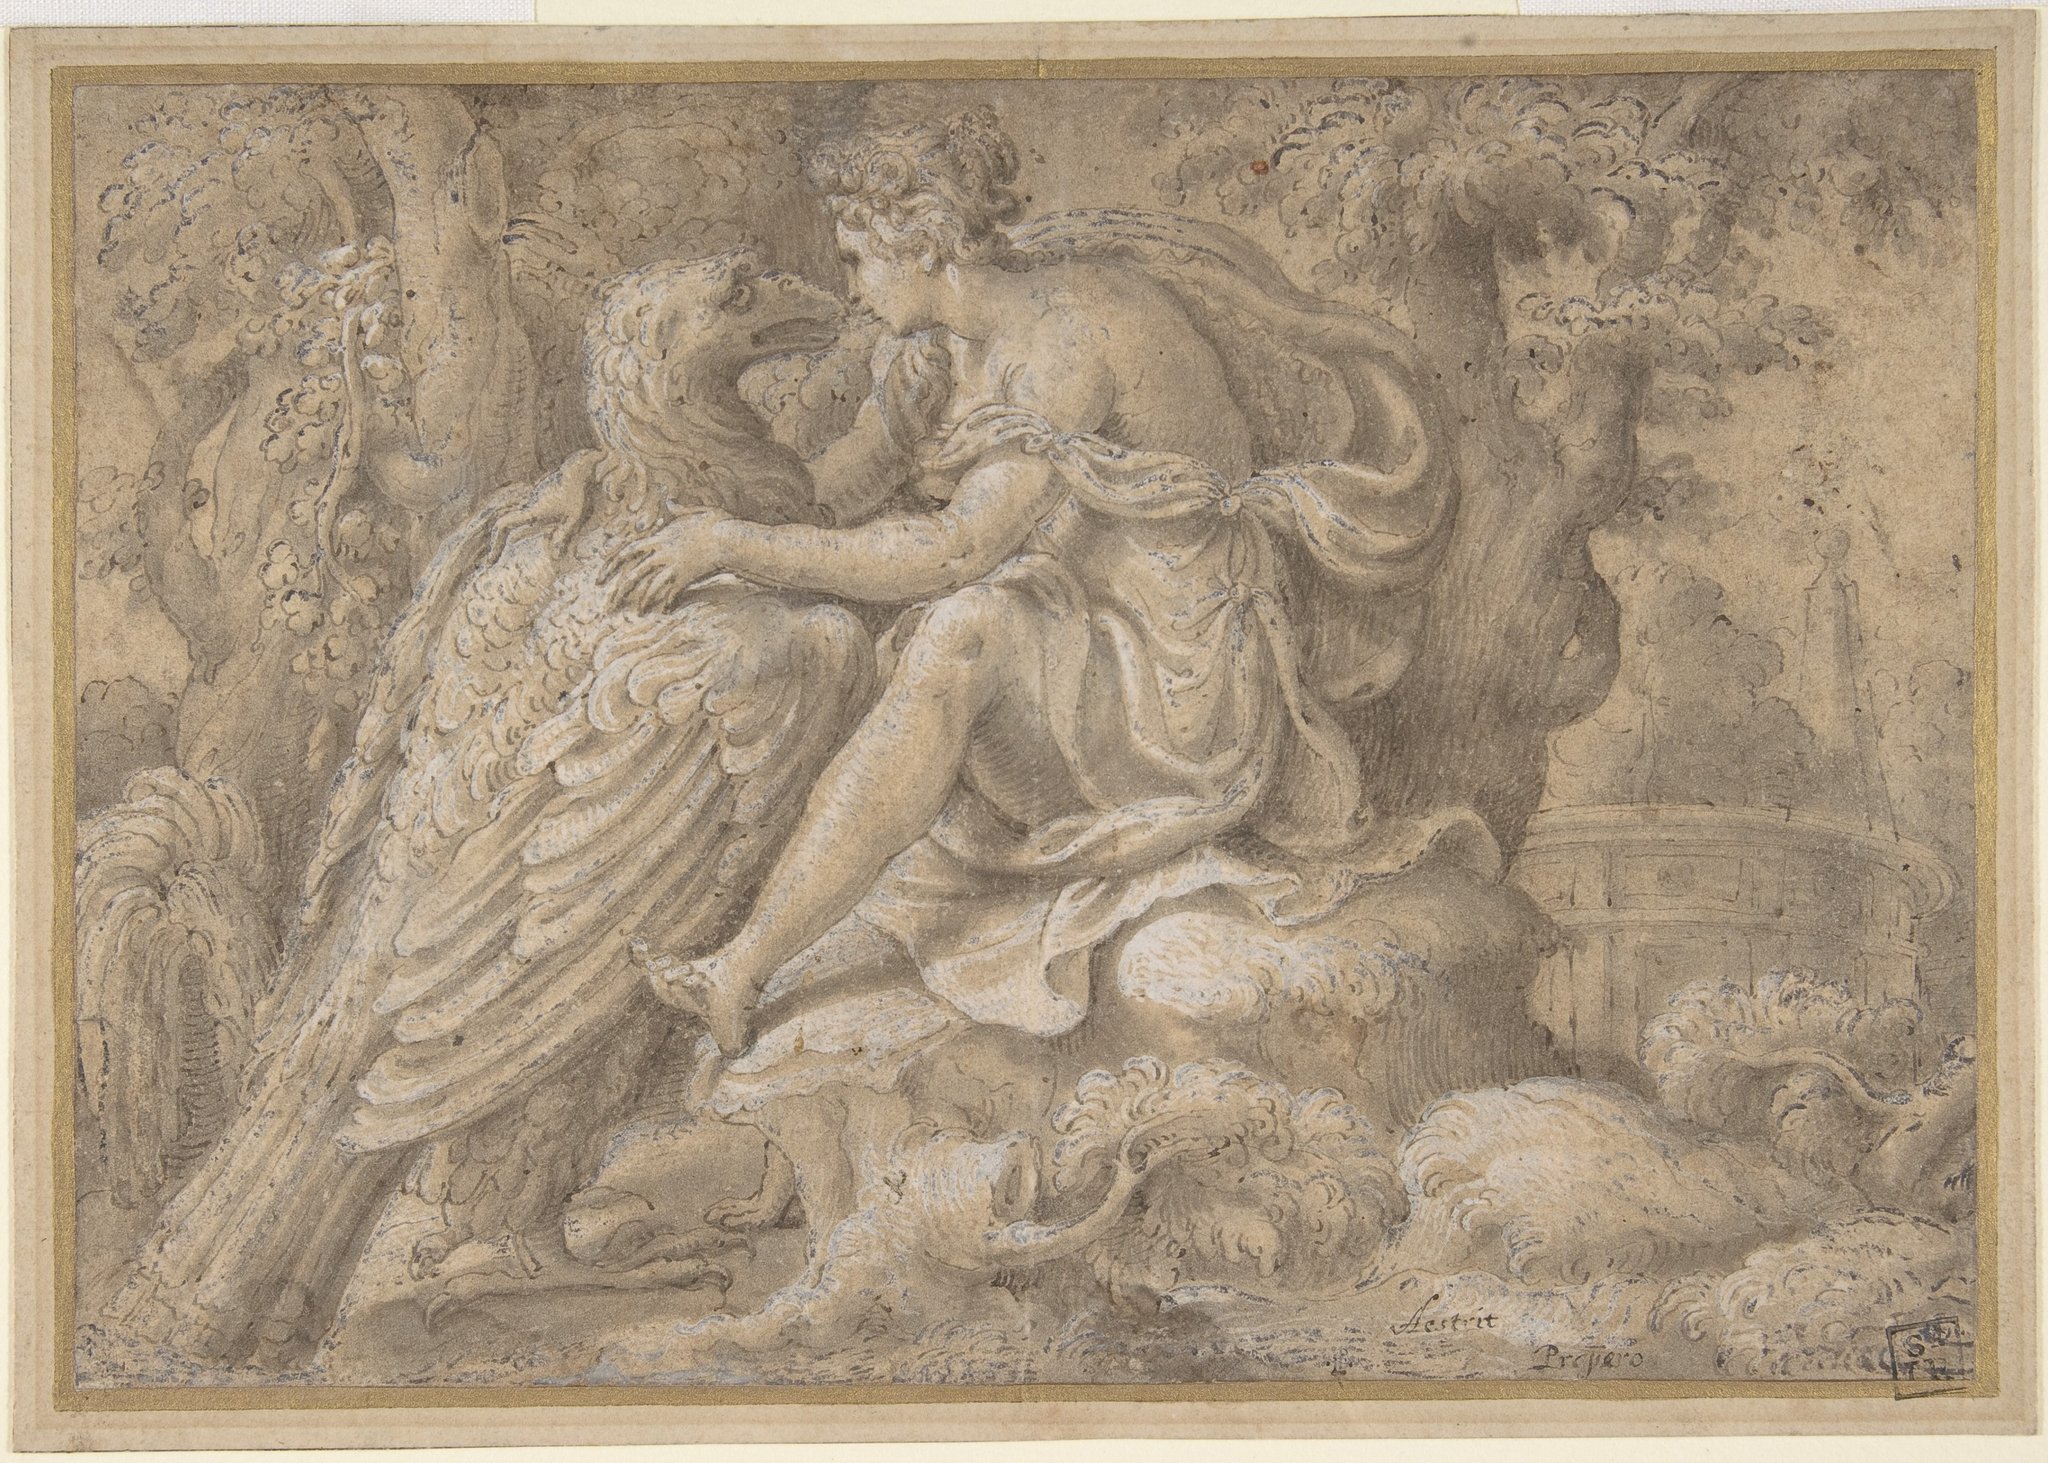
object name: drawing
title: Jupiter and Astraea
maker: giulio campi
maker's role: artist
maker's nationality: italian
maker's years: 1502-1572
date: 1545-1550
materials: gouache, ink, paper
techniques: brush, highlighting, pen, tinting, wash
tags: jupiter,trees,goddess